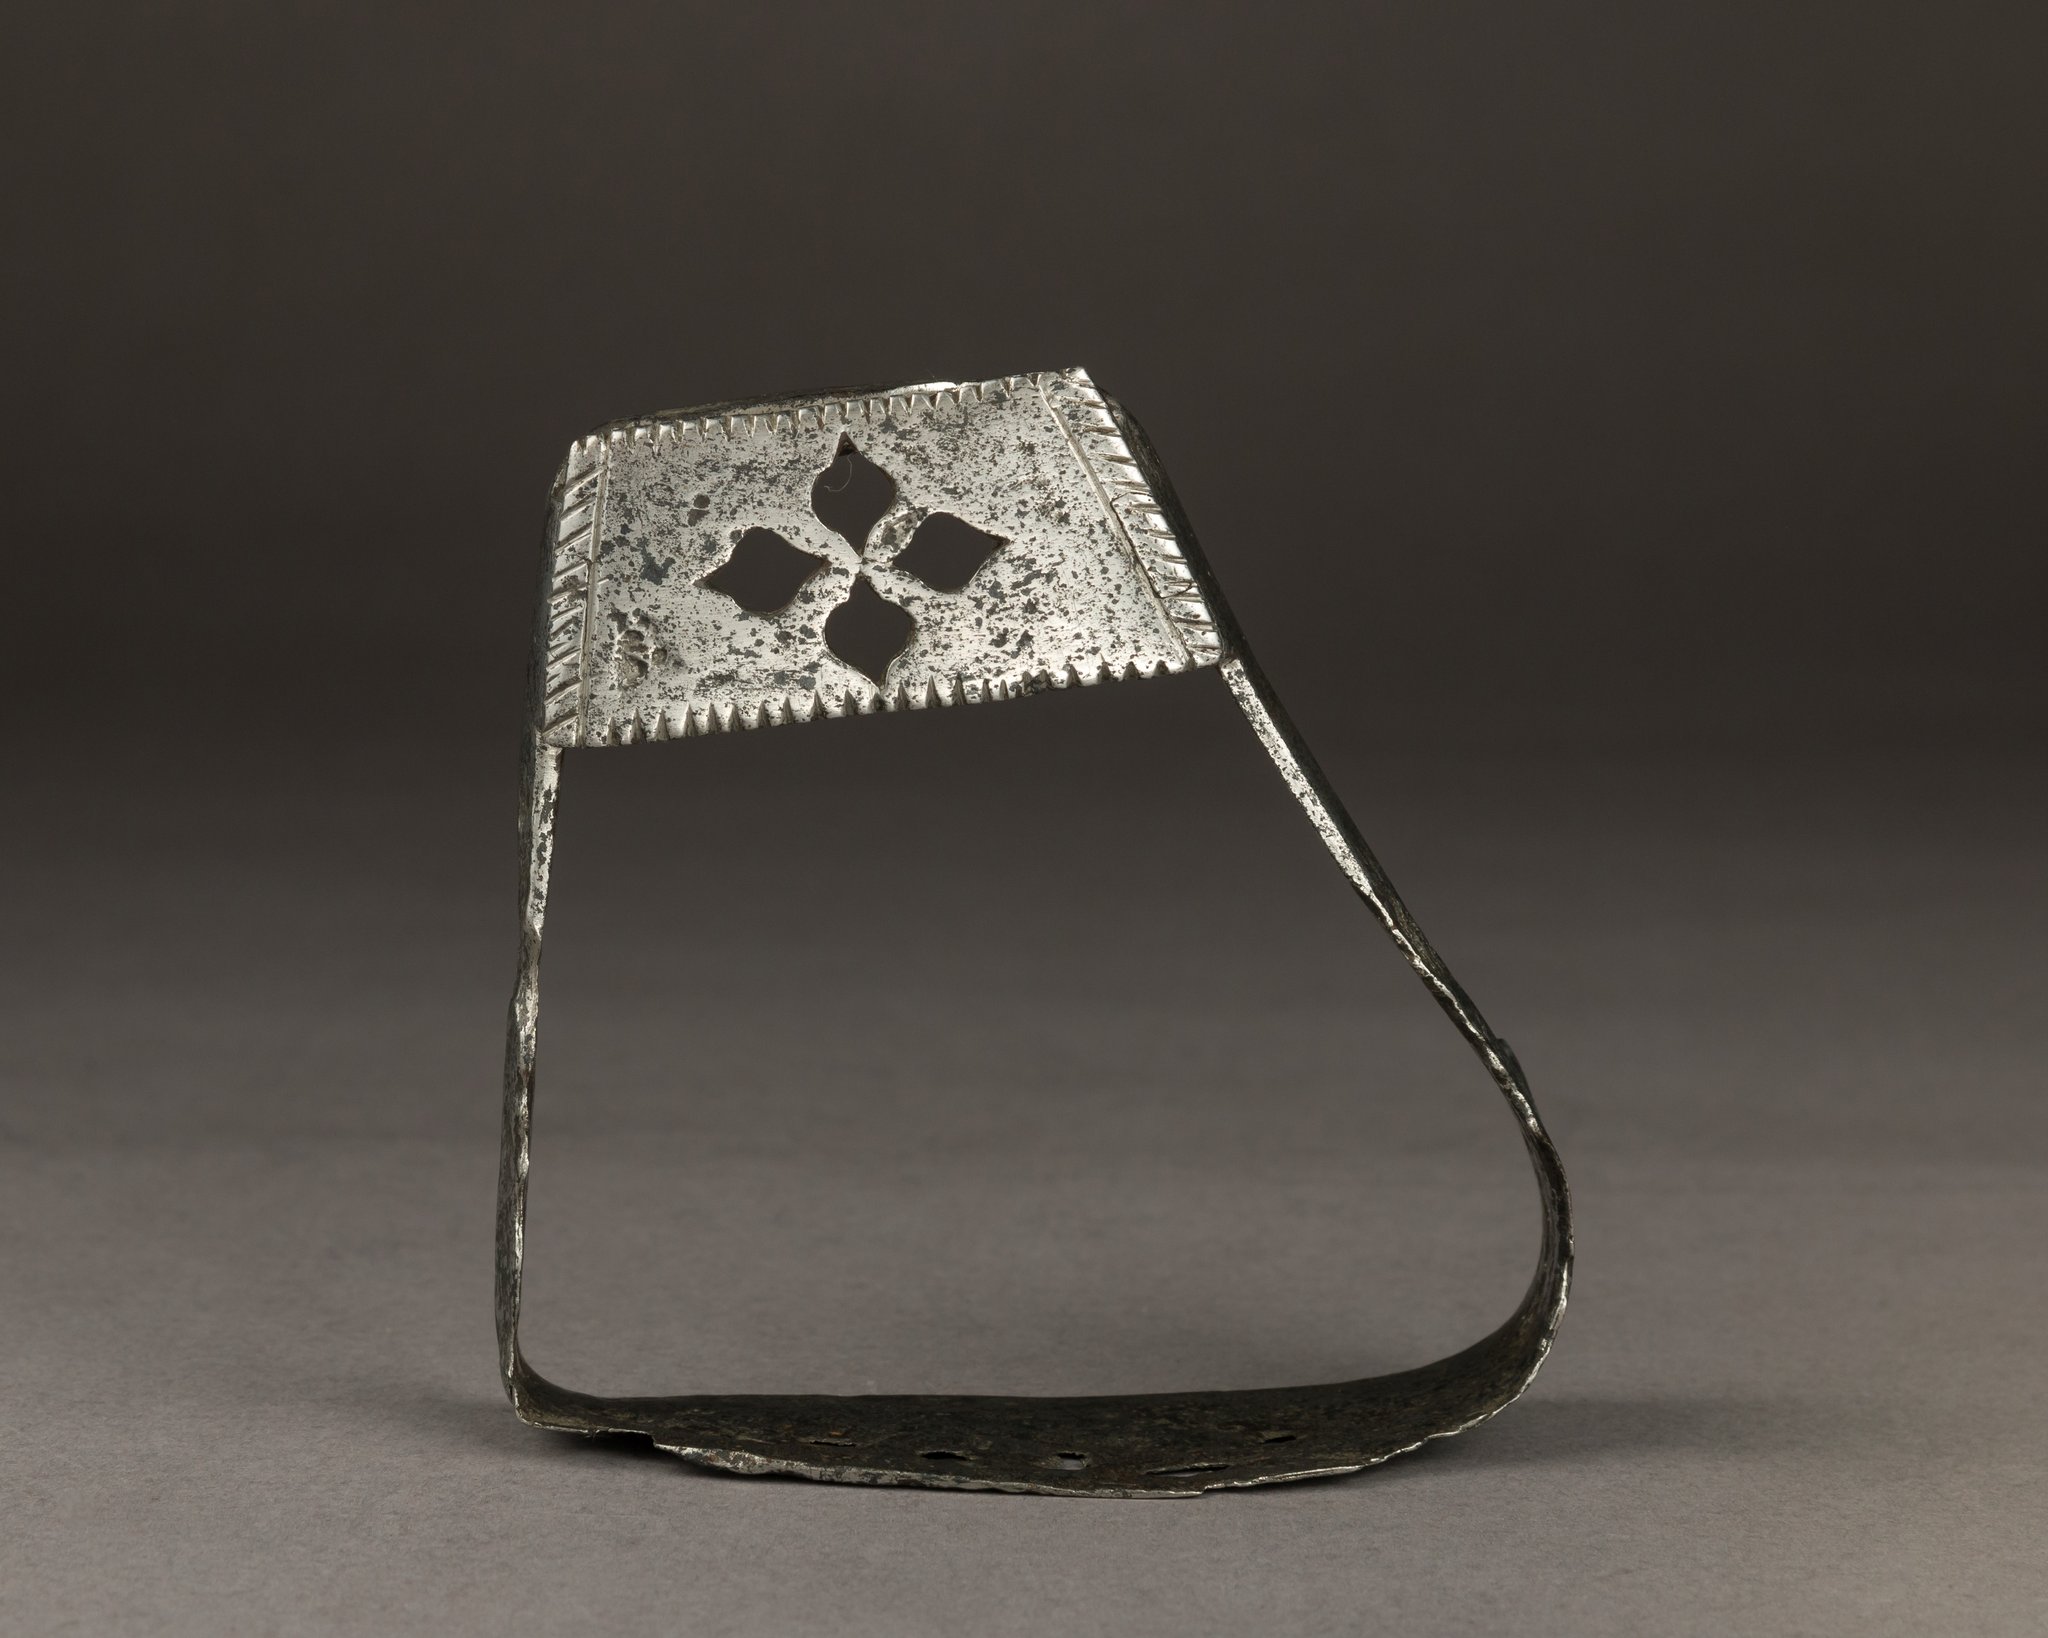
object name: stirrup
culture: german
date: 1401-1450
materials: iron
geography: germany